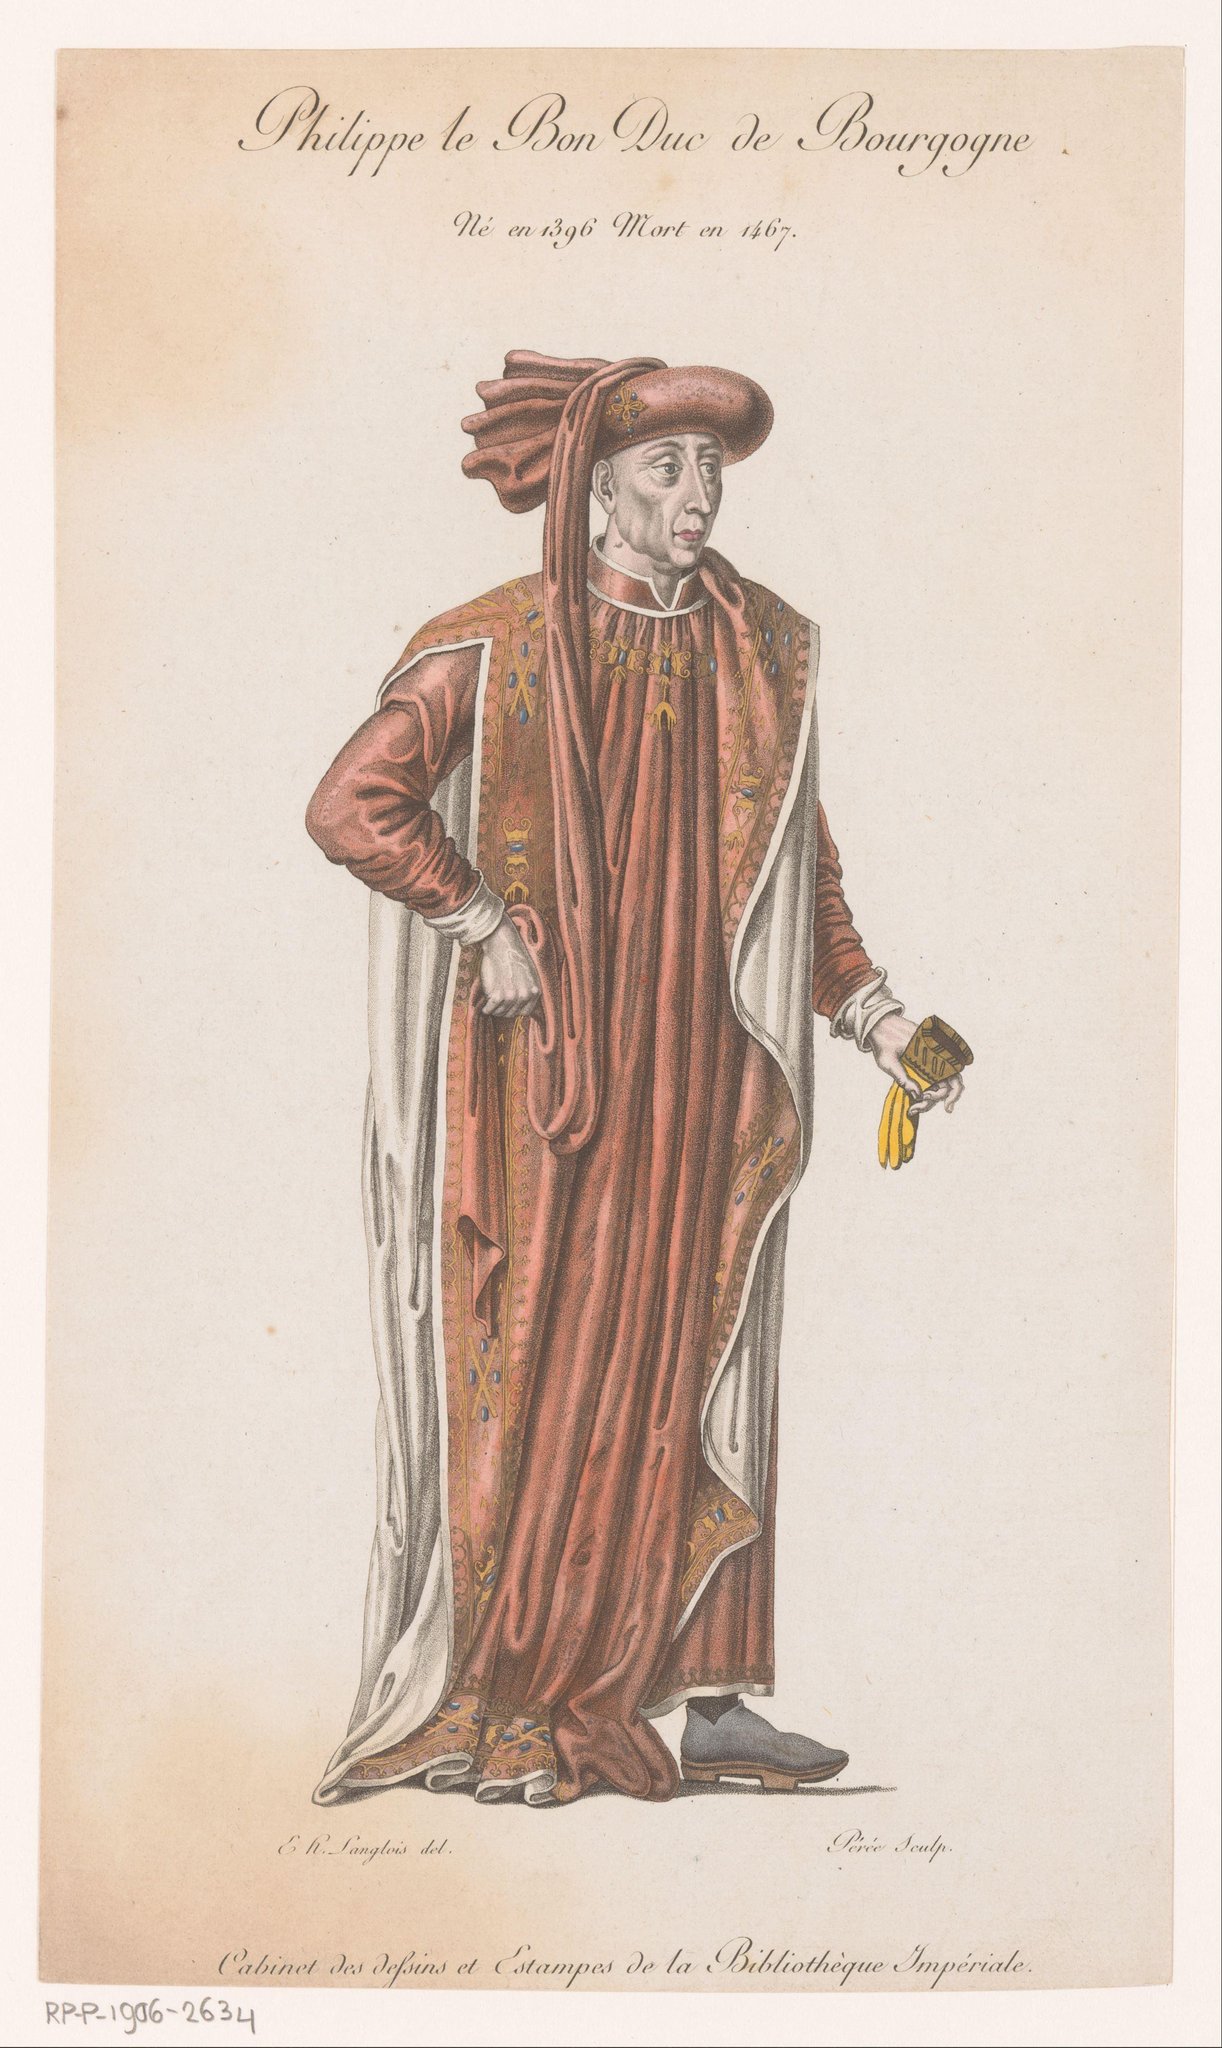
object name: print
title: Philippe le Bon Duc de Bourgogne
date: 1815-1830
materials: paper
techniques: etching, hand coloring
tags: bruges, philip iii the good, historical persons, ruler, sovereign, knighthood order of the golden fleece - insignia of a knighthood order, e.g.: badge, chain (with name of order)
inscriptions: collector's mark: Lugt 2228